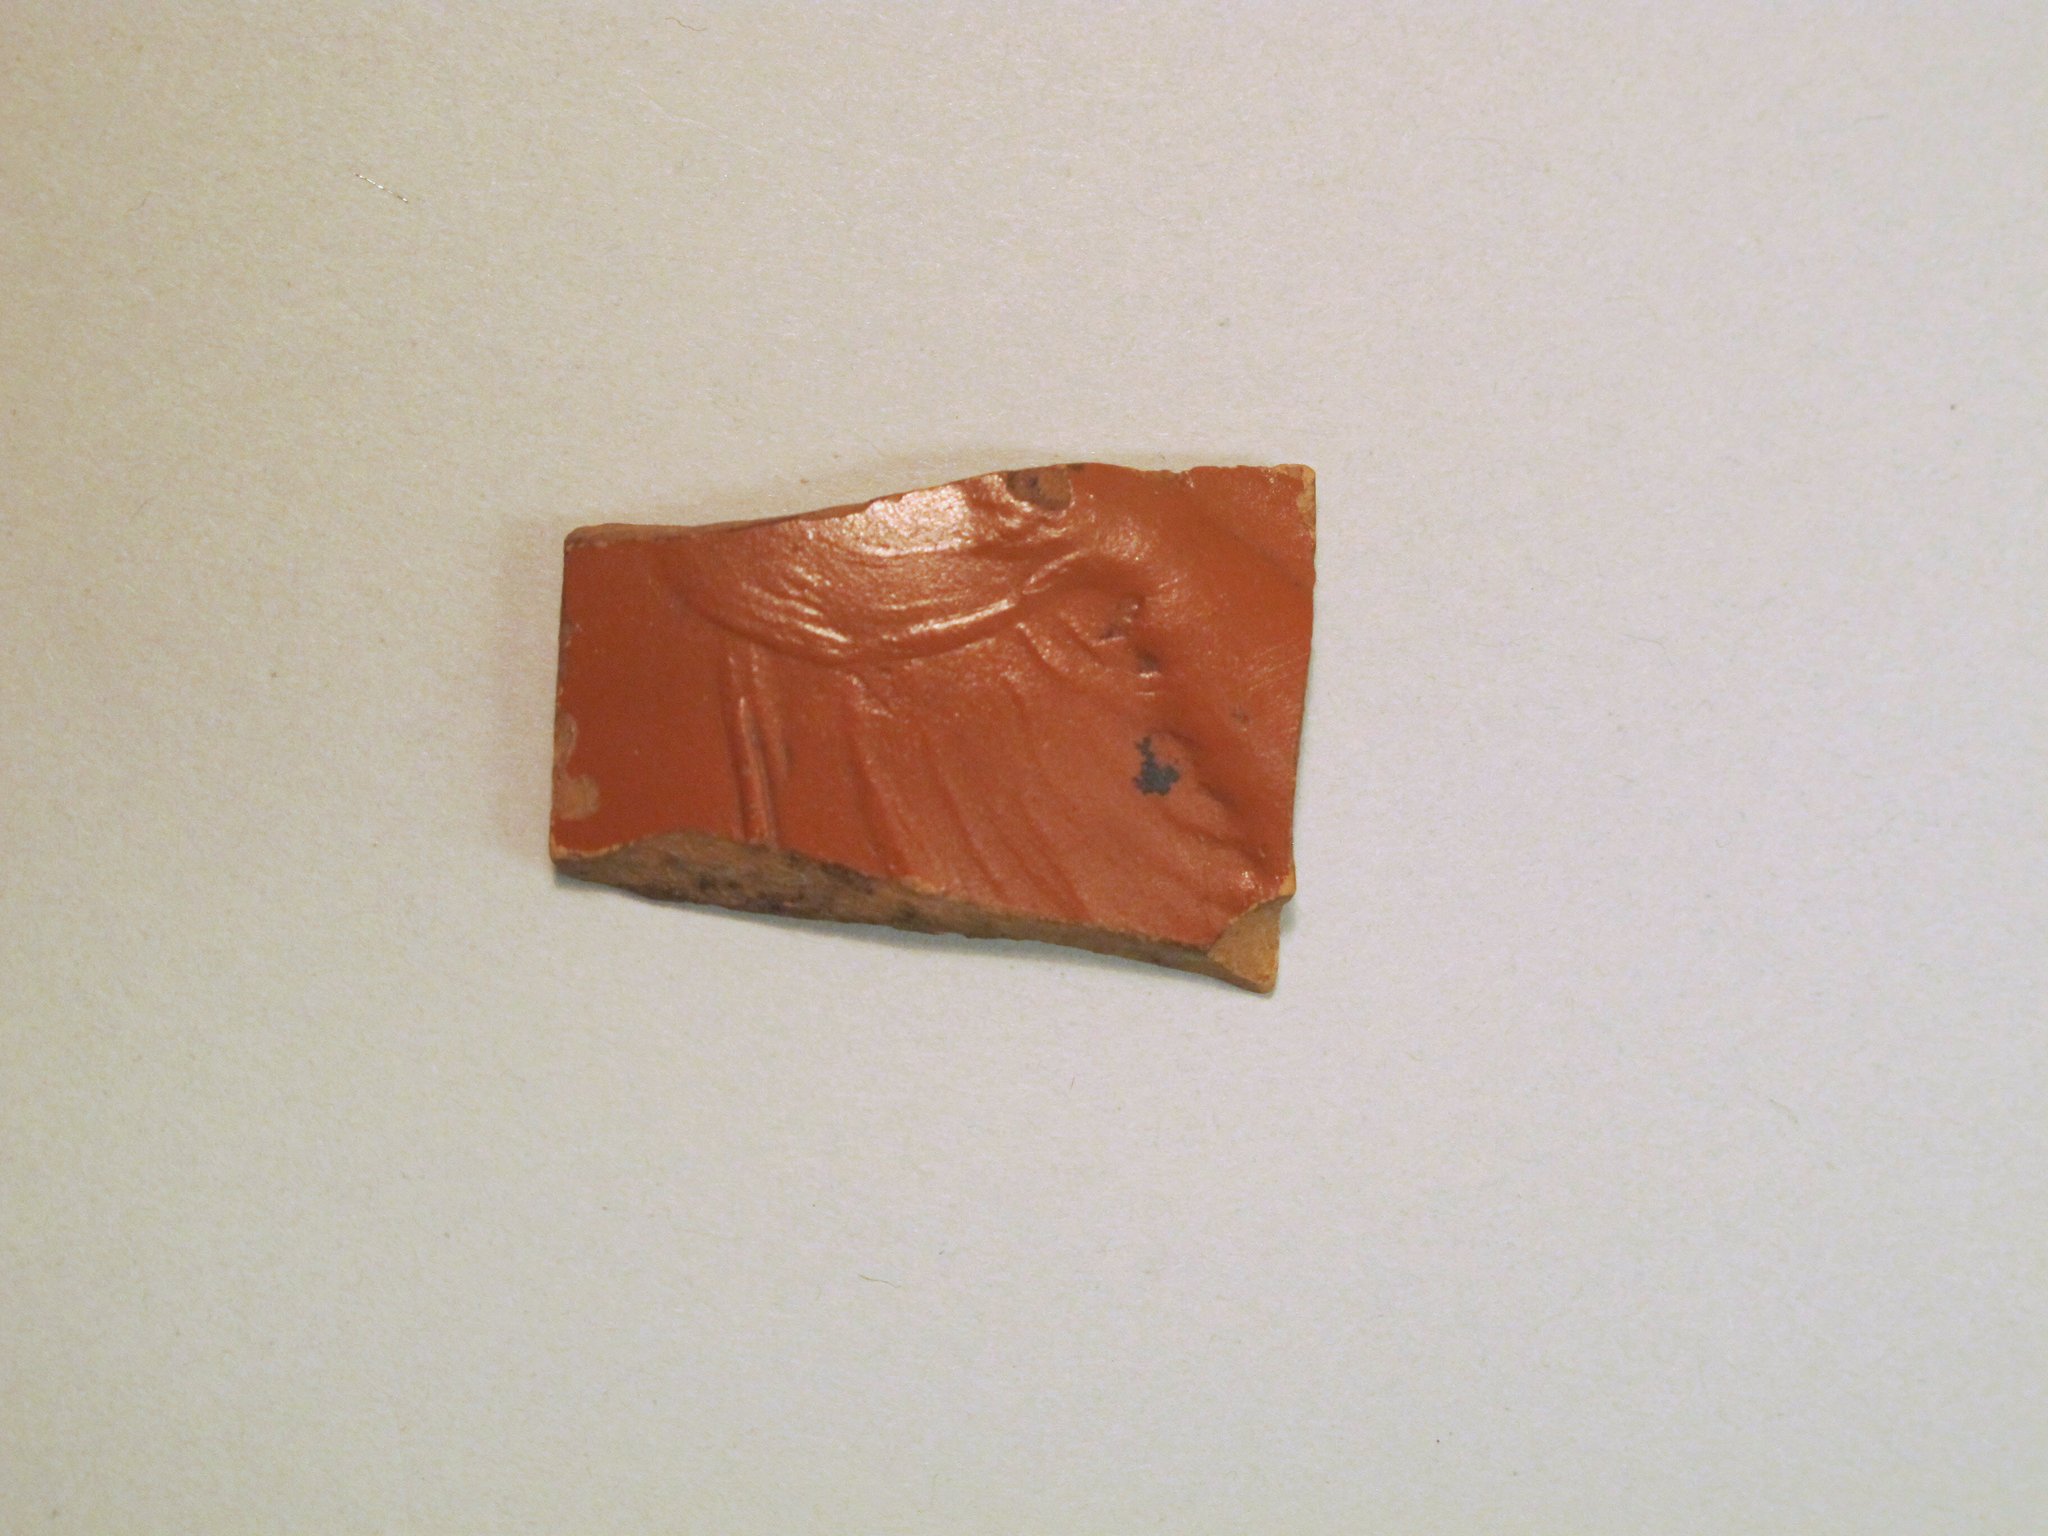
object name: vase fragment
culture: roman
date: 670 BCE-330 CE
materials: terracotta